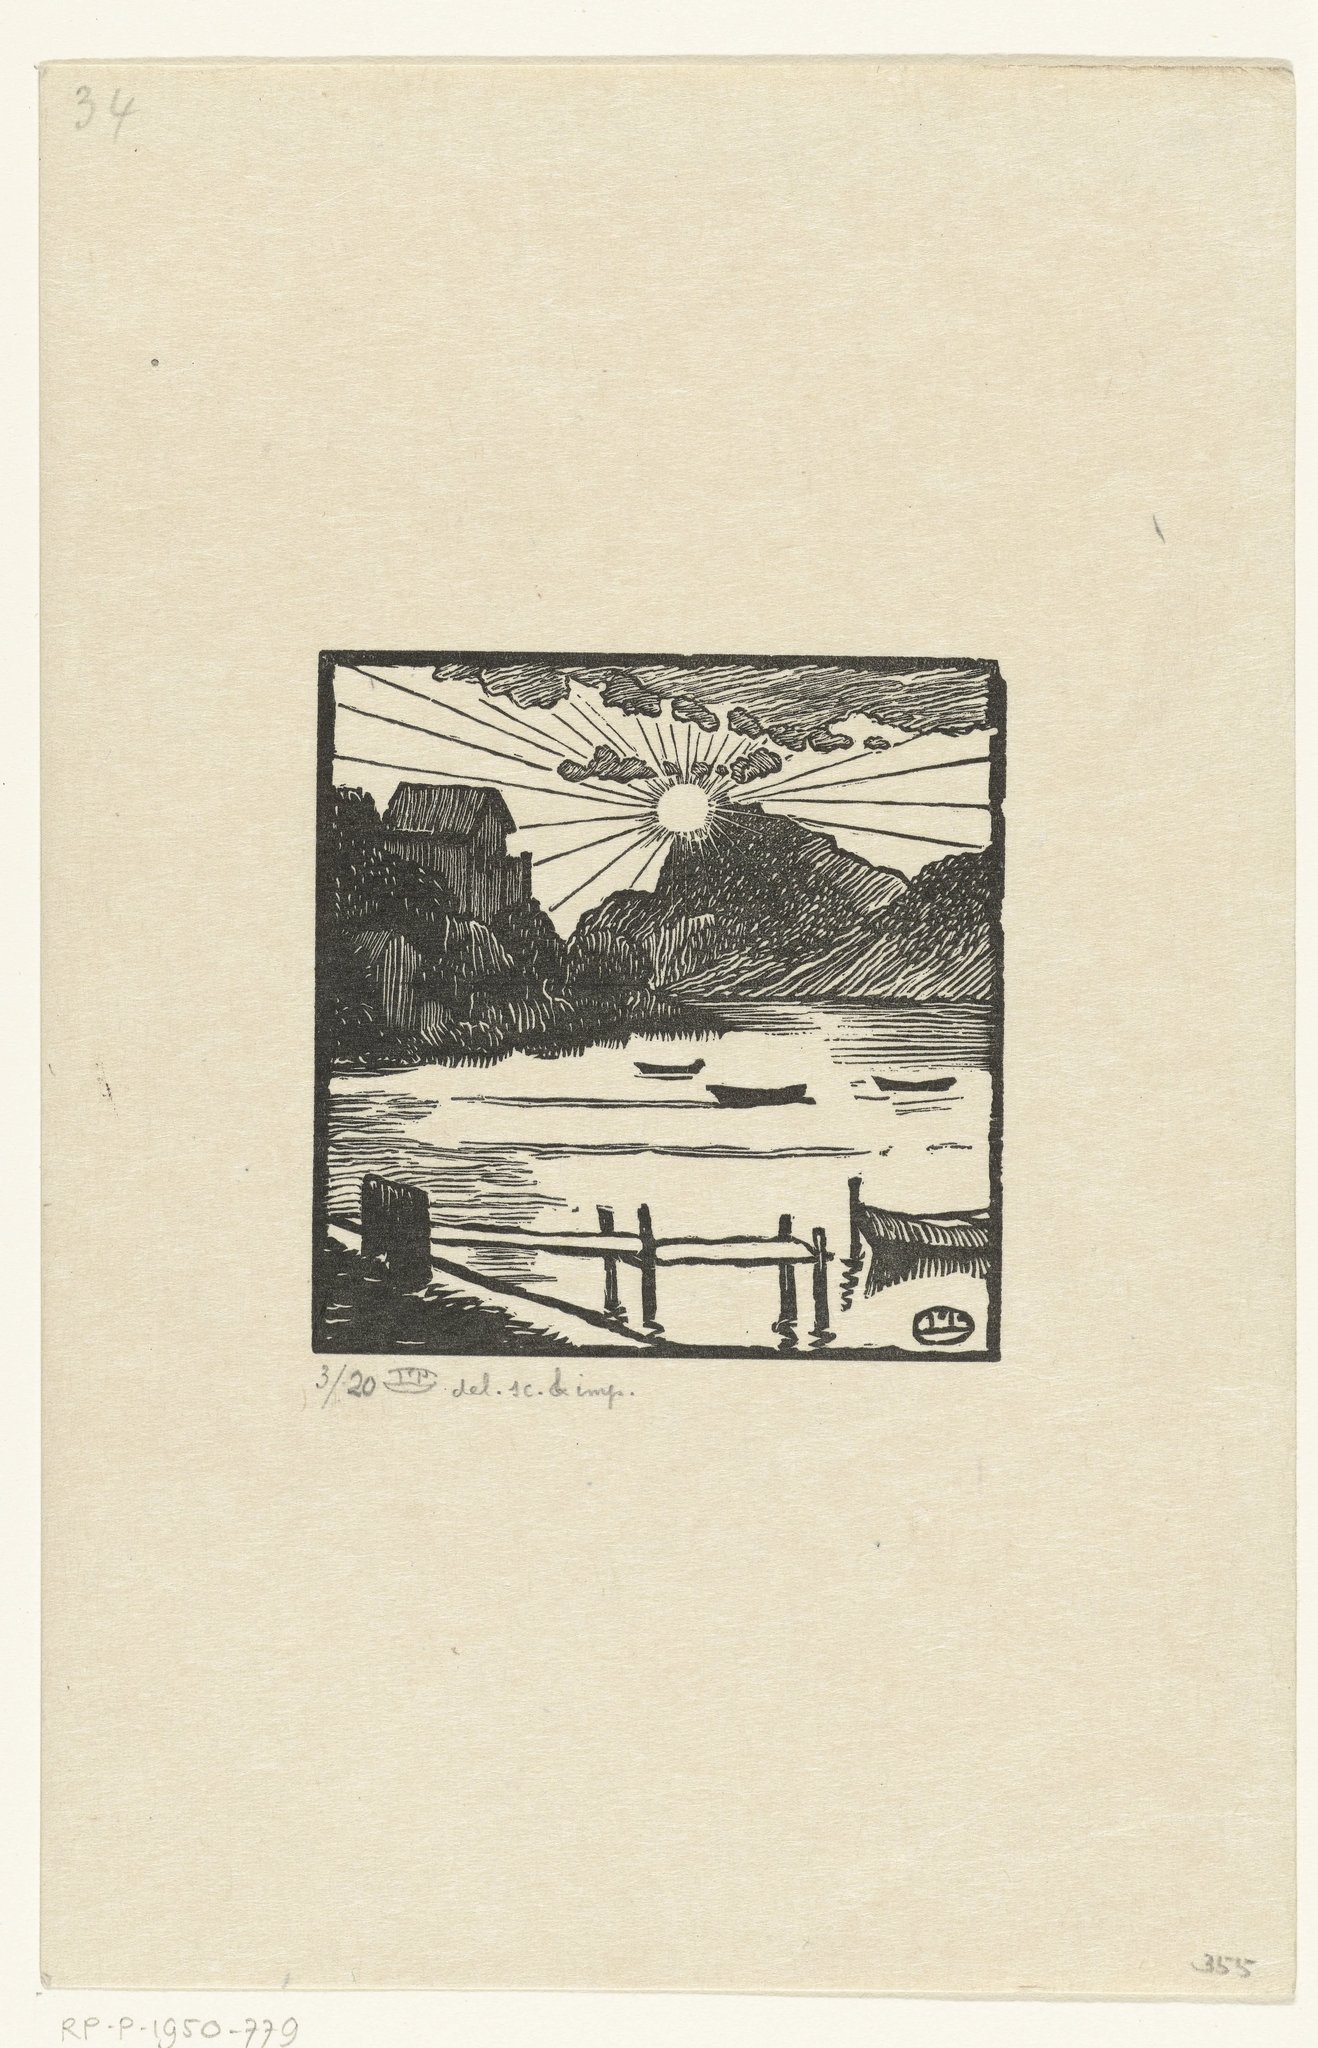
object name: print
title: Zonsopgang boven een meer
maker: lucien pissarro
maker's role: painter, print maker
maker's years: 1863-1944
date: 1927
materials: paper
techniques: engraving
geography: hammersmith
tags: lake, sunrise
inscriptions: collector's mark: Lugt 2228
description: Landschap met een zonsopgang bij een meer.